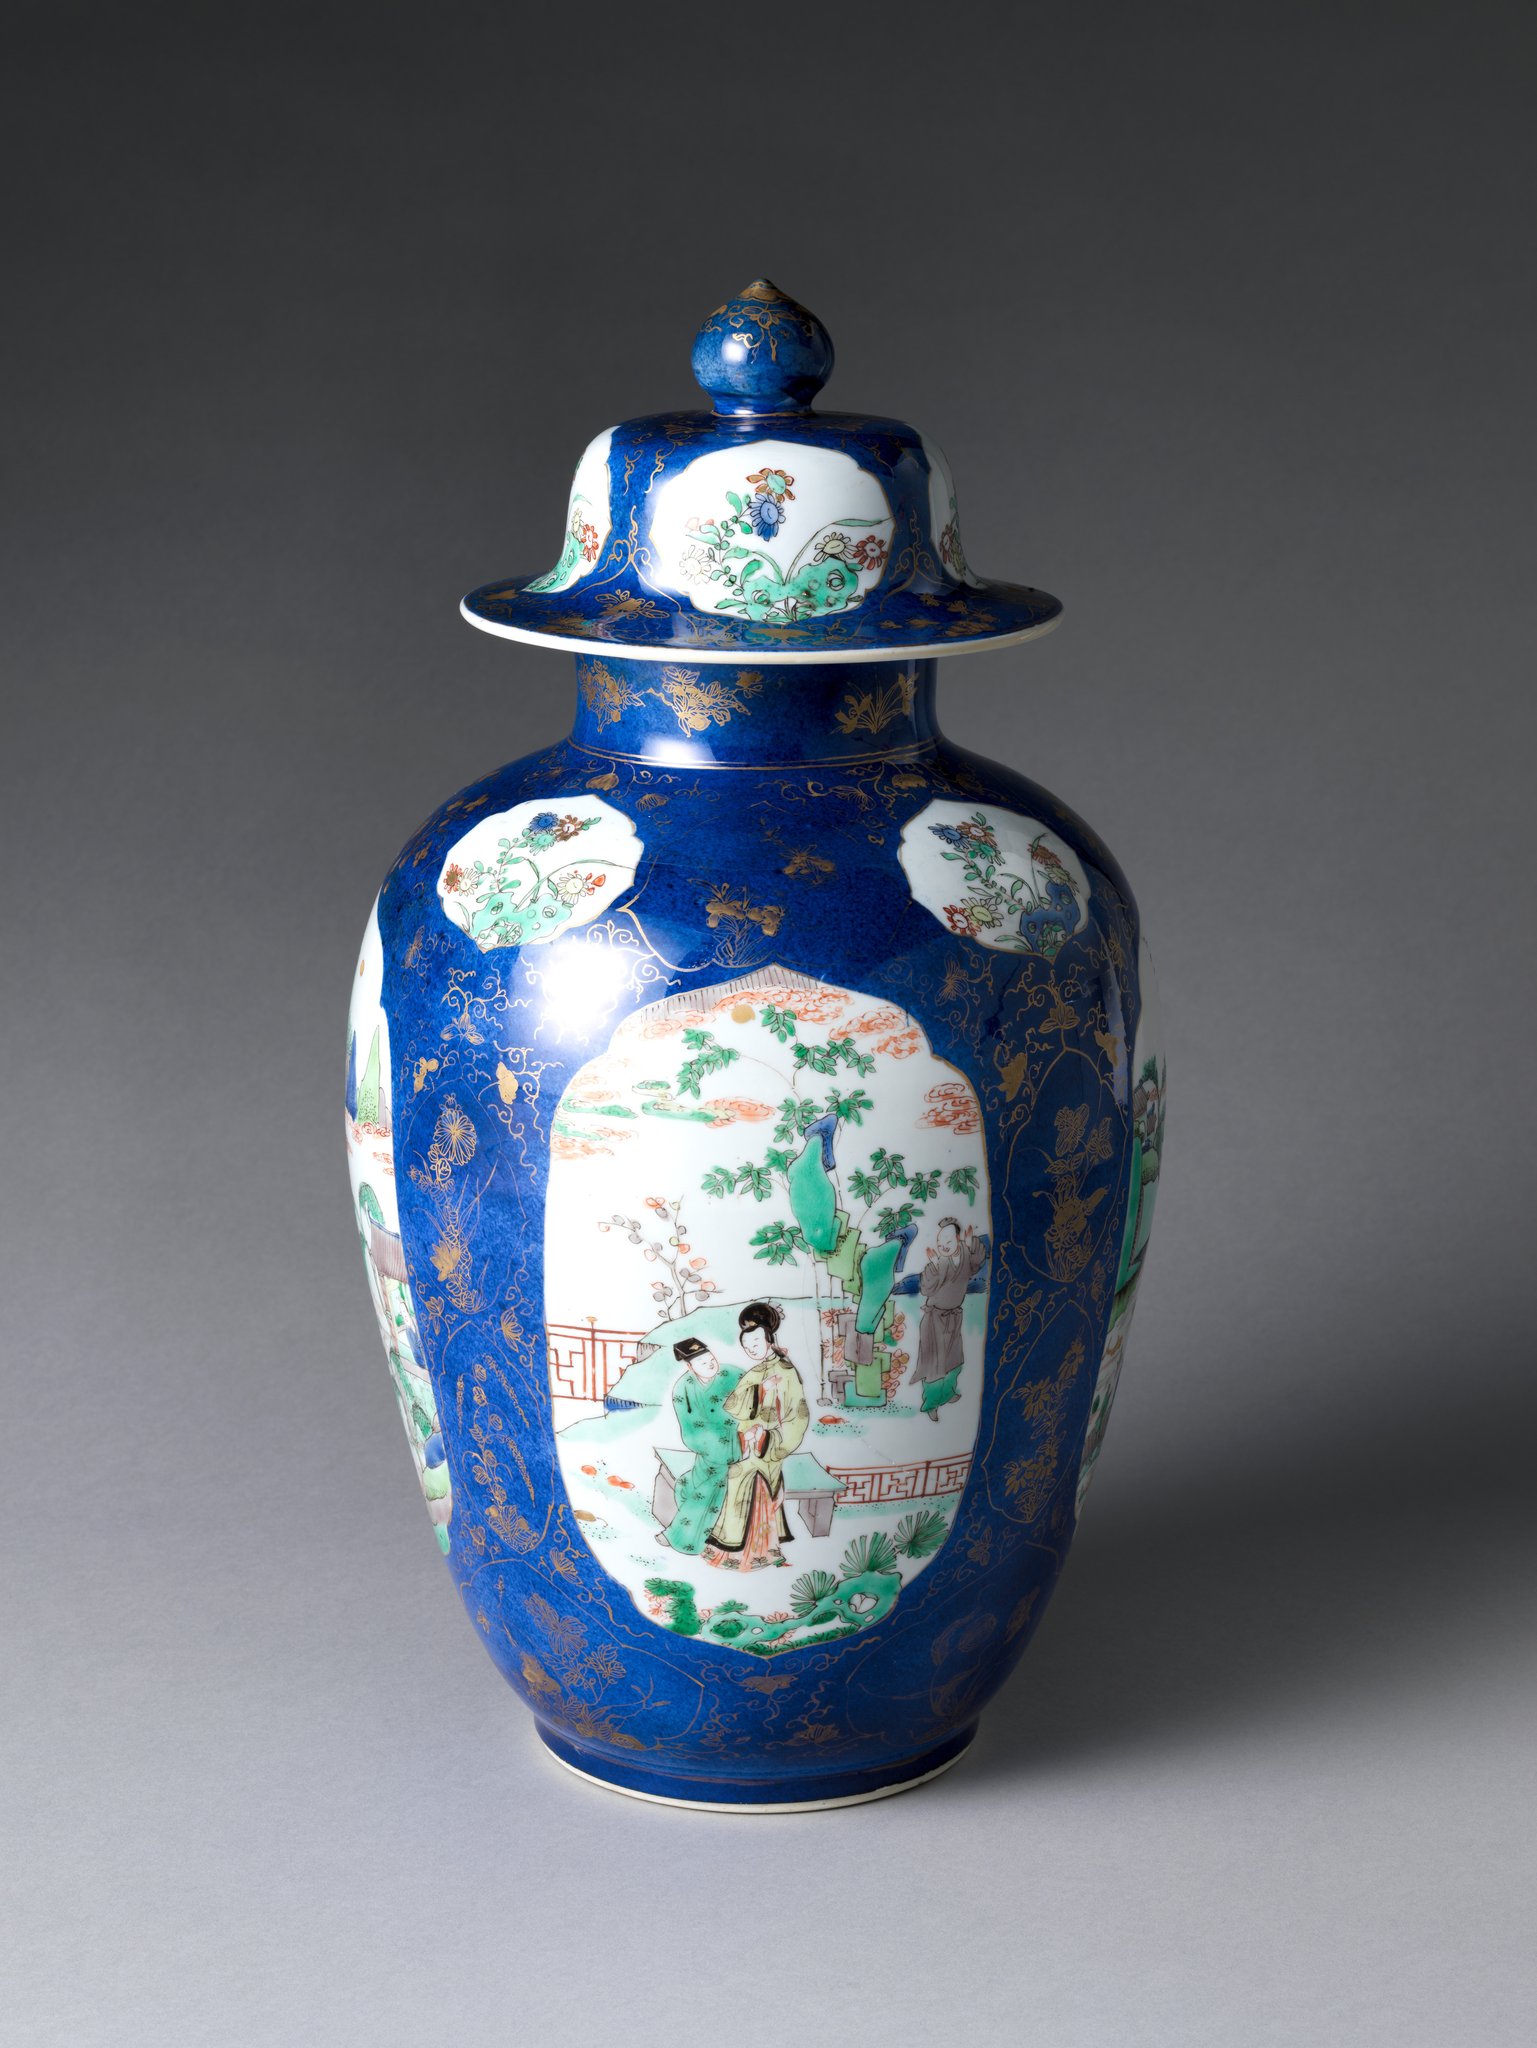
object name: jar with cover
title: Jar with Landscape Scenes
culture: chinese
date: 1667-1733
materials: enamel, glaze, gold, porcelain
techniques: painting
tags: landscapes